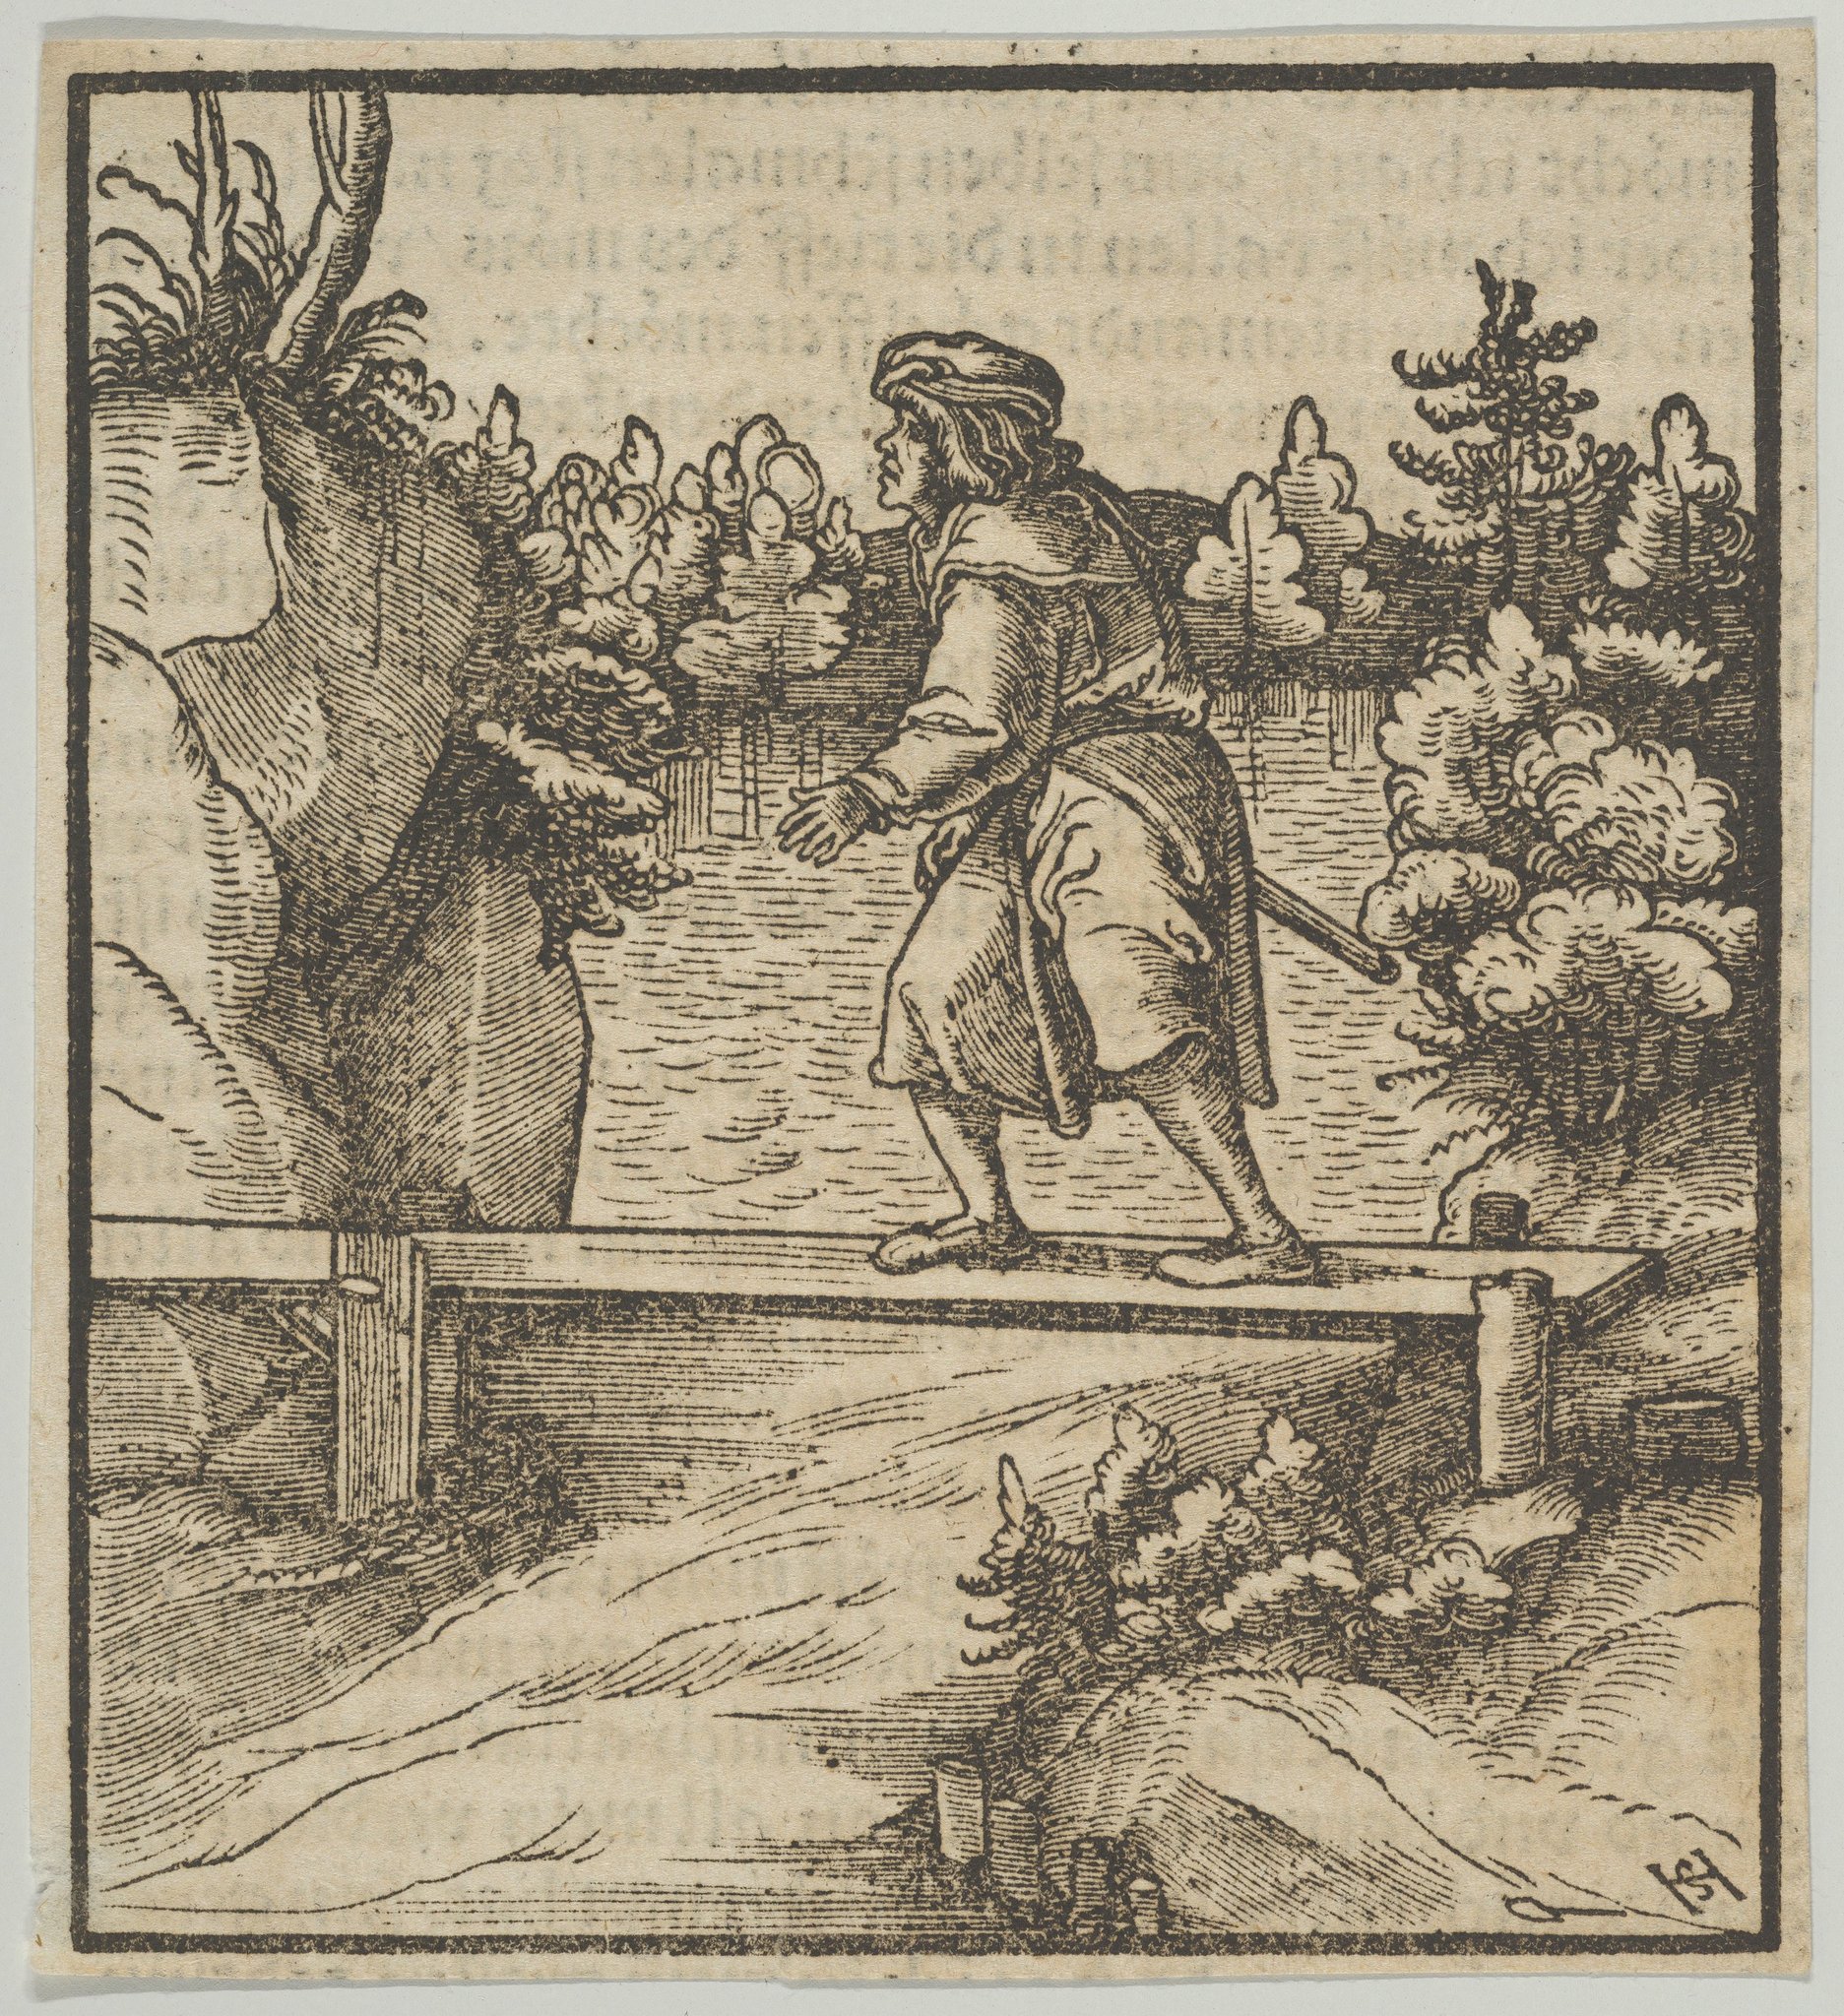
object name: print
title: A Man Crossing a Small Bridge, from Hymmelwagen auff dem, wer wol lebt...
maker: hans schäufelein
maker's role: artist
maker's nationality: german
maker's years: 1480-1540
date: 1517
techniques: woodcut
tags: bridges,men